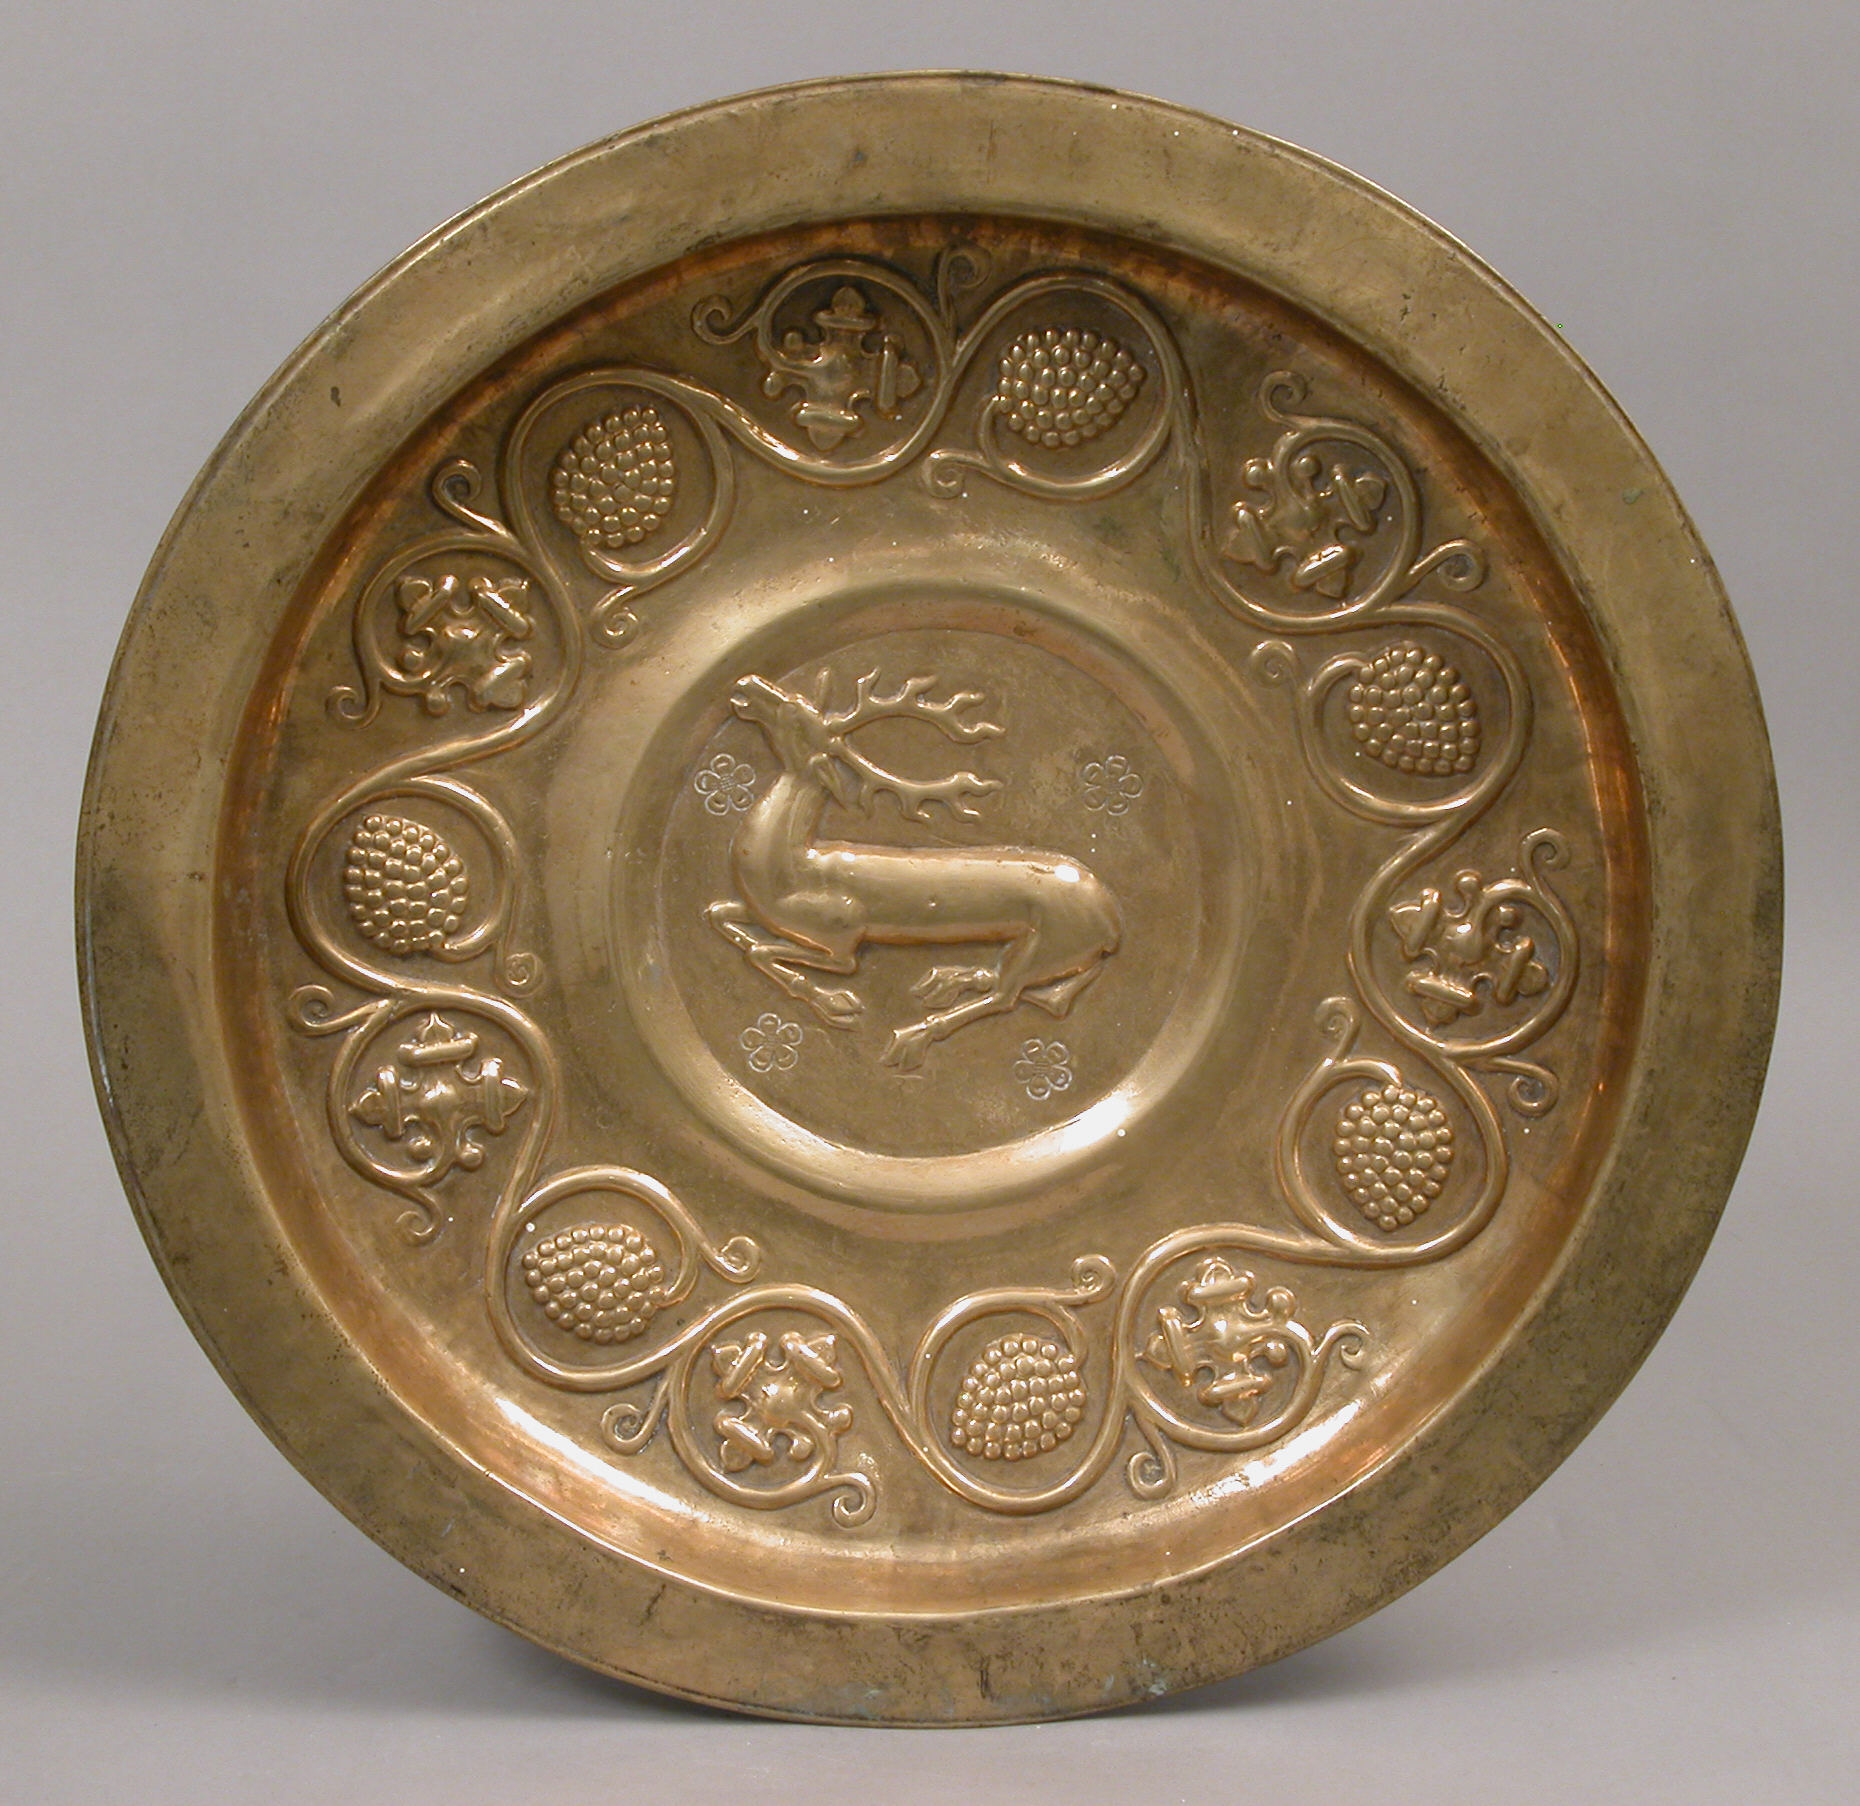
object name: plate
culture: german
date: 1467-1500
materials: brass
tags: deer